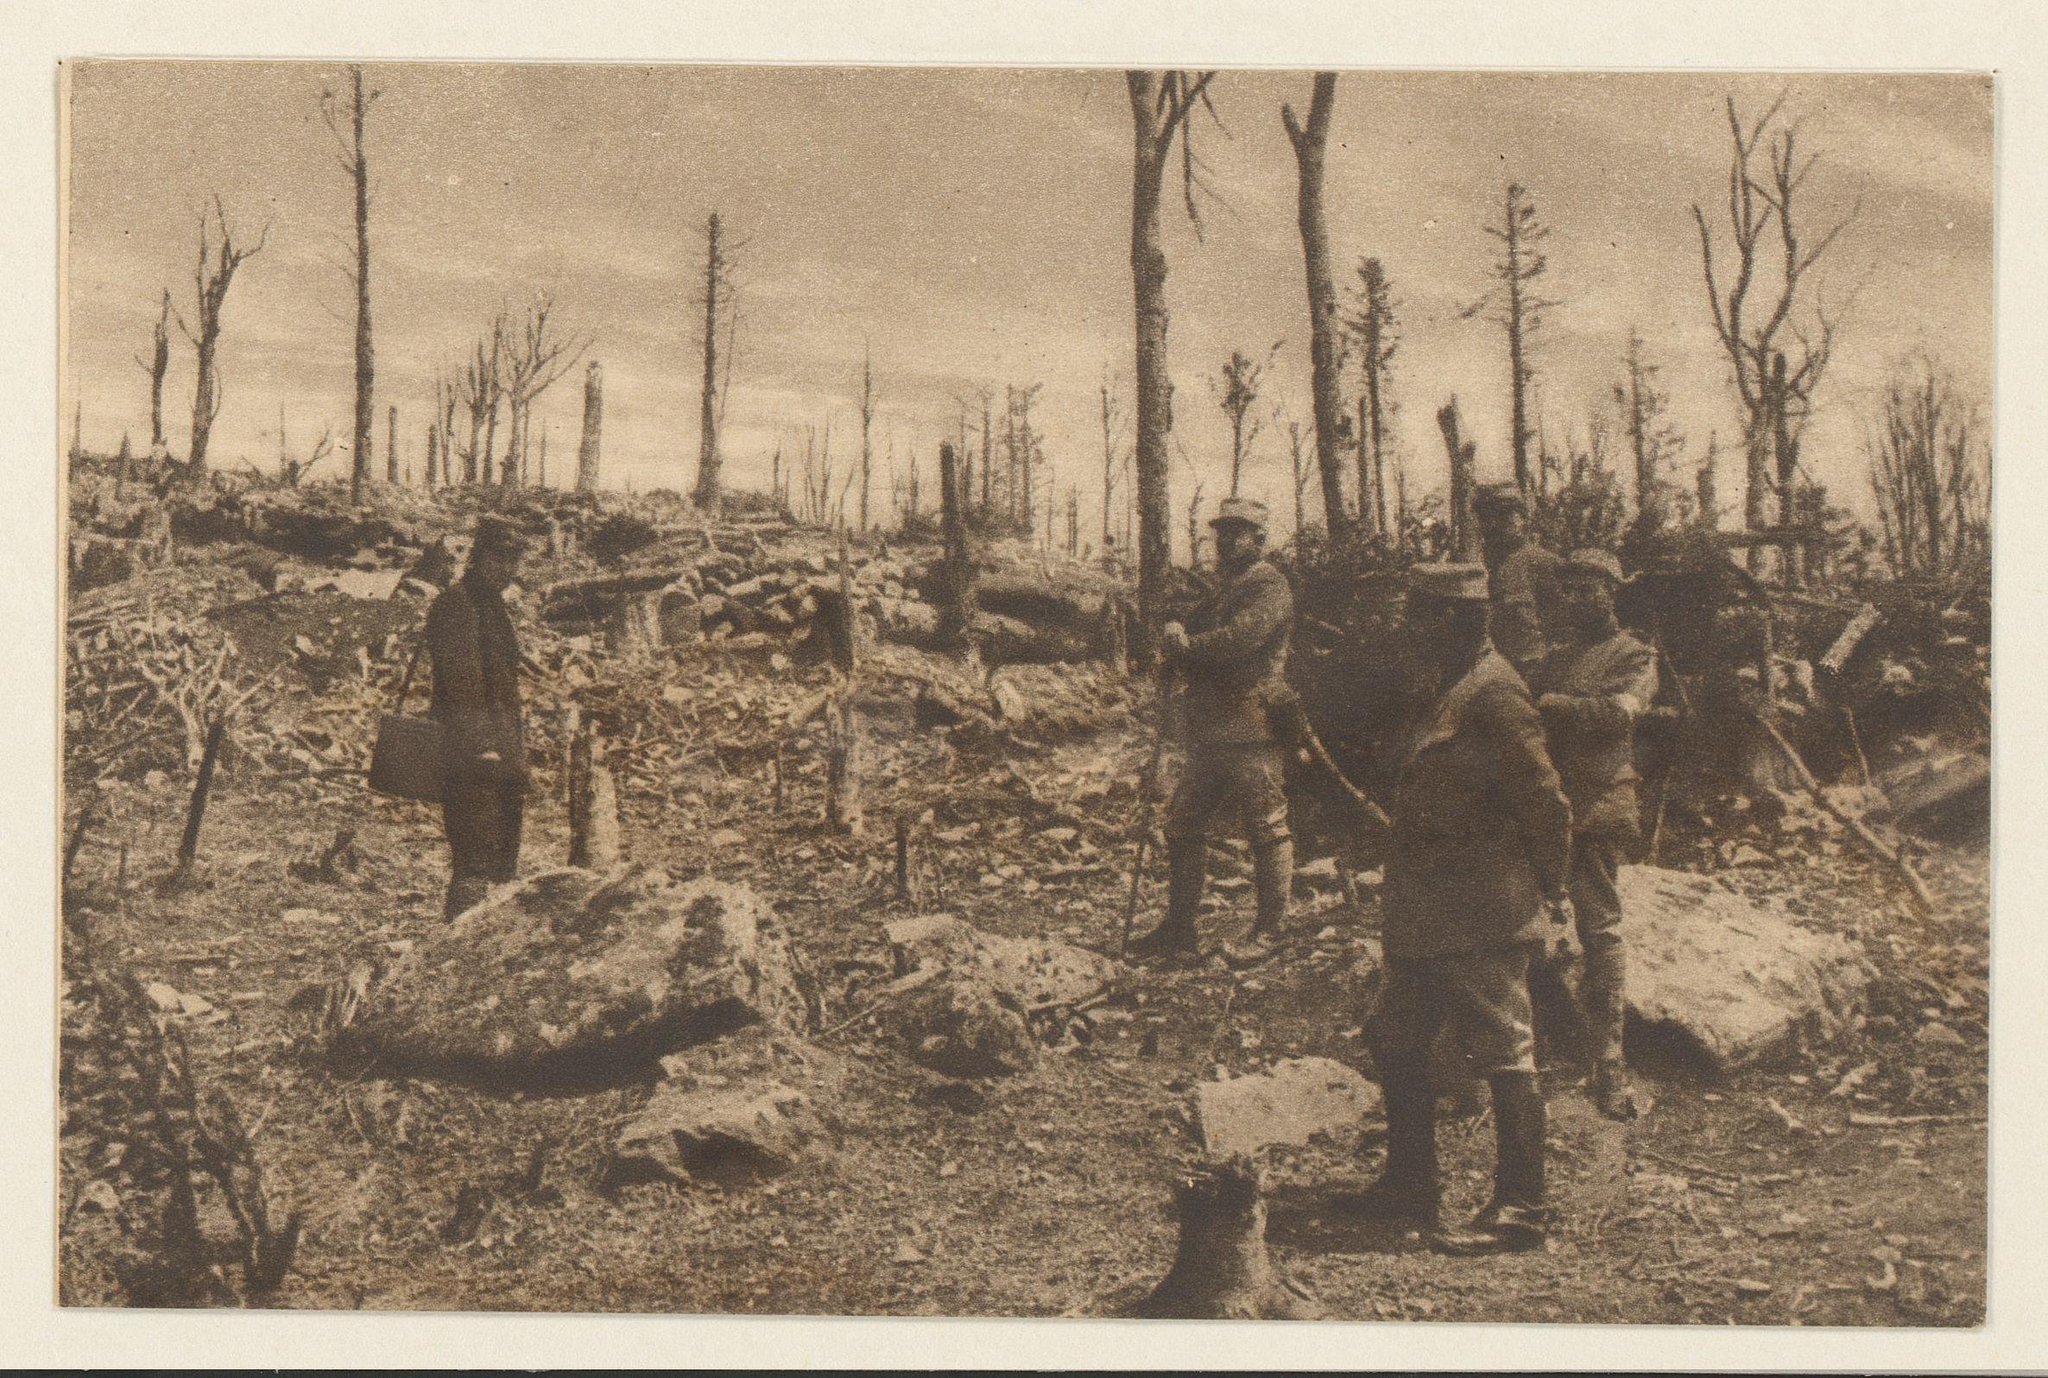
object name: ansichtkaart, prentbriefkaart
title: Het woud op den kruin van den Hartmannswillerkopf (...) is door het geschut totaal vernietigd geworden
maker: sémaphore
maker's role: printer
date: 1914-1915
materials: paper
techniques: photograph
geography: marseille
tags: forest, wood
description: Kapotgeschoten bos. Onderdeel van de eerste serie van twaalf (elf aanwezig) prentbriefkaarten over de Eerste Wereldoorlog, 1914-1915.